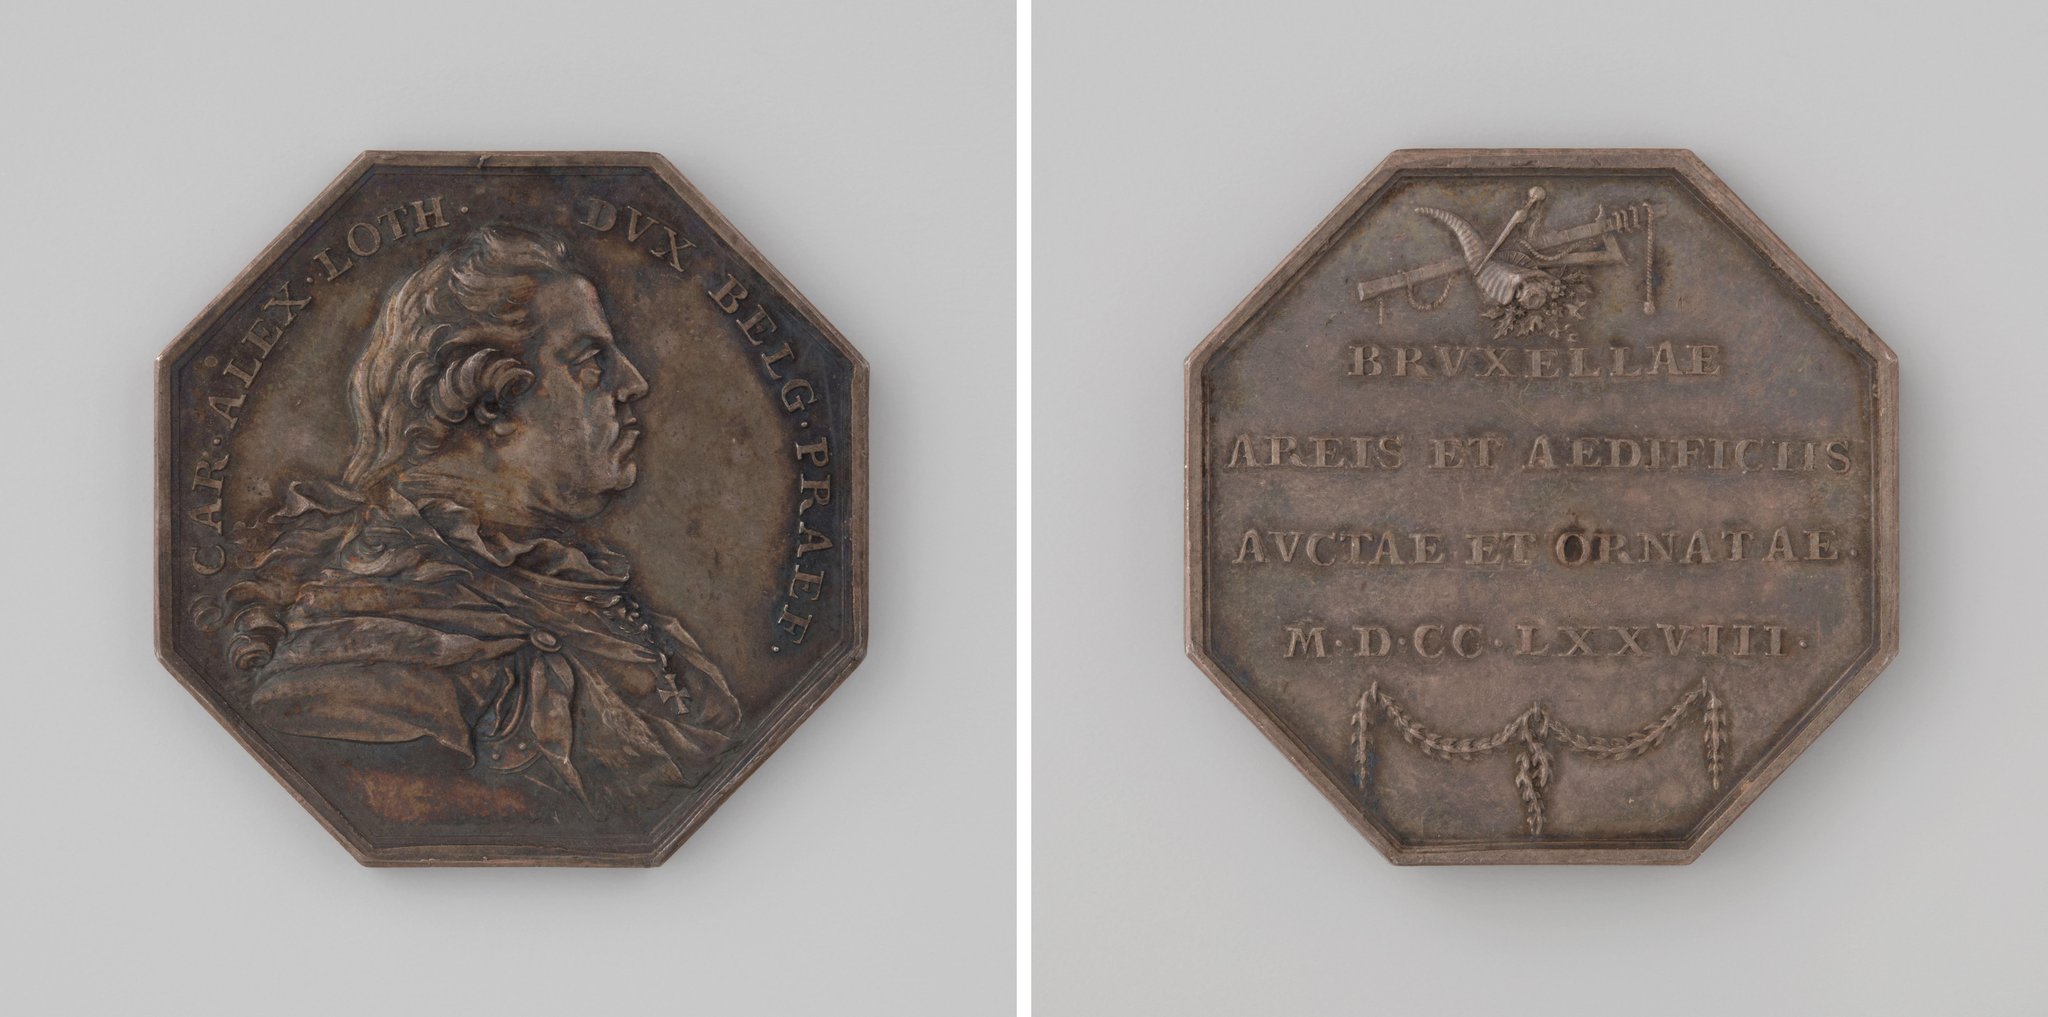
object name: history medal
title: Karel Alexander, hertog van Lotharingen-Bar, beschermheer der bouwkunst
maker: Anonymous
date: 1778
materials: silver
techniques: striking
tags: karel alexander hertog van lotharingen, brussels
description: Zilveren achthoekige penning. Voorzijde: borststuk man binnen omschrift. Keerzijde: opschrift onder siermotief opgebouwd uit hoorn van overvloed, passer, meetlat en winkelhaak boven bloemenkrans